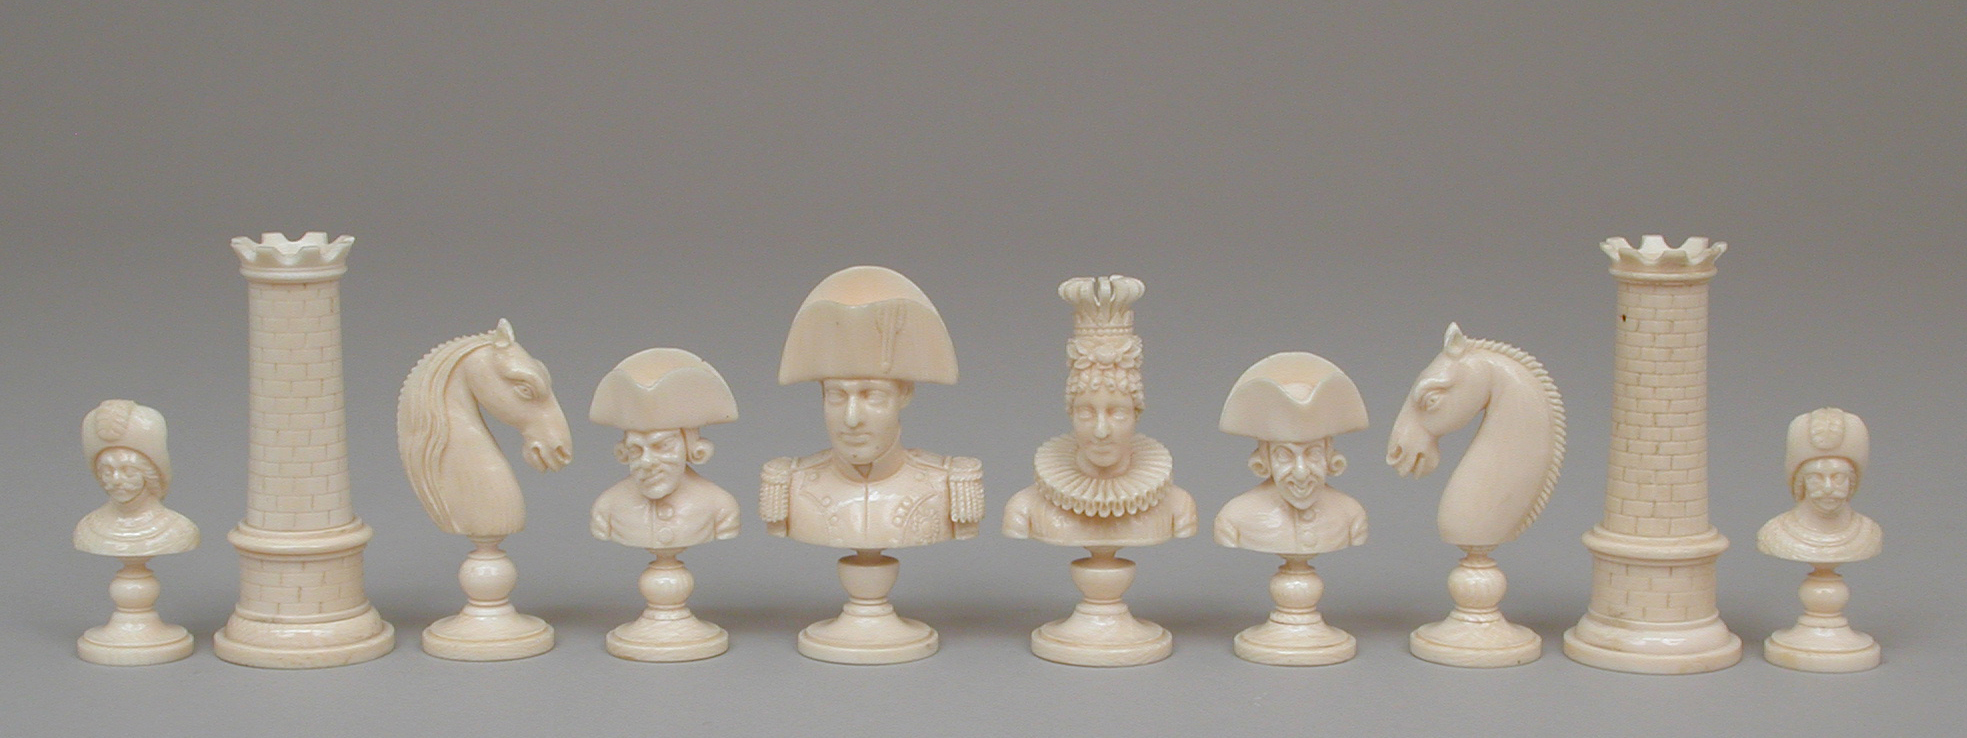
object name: chessman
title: Battle of Waterloo chessmen (32)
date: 1801-1900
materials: ivory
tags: chess